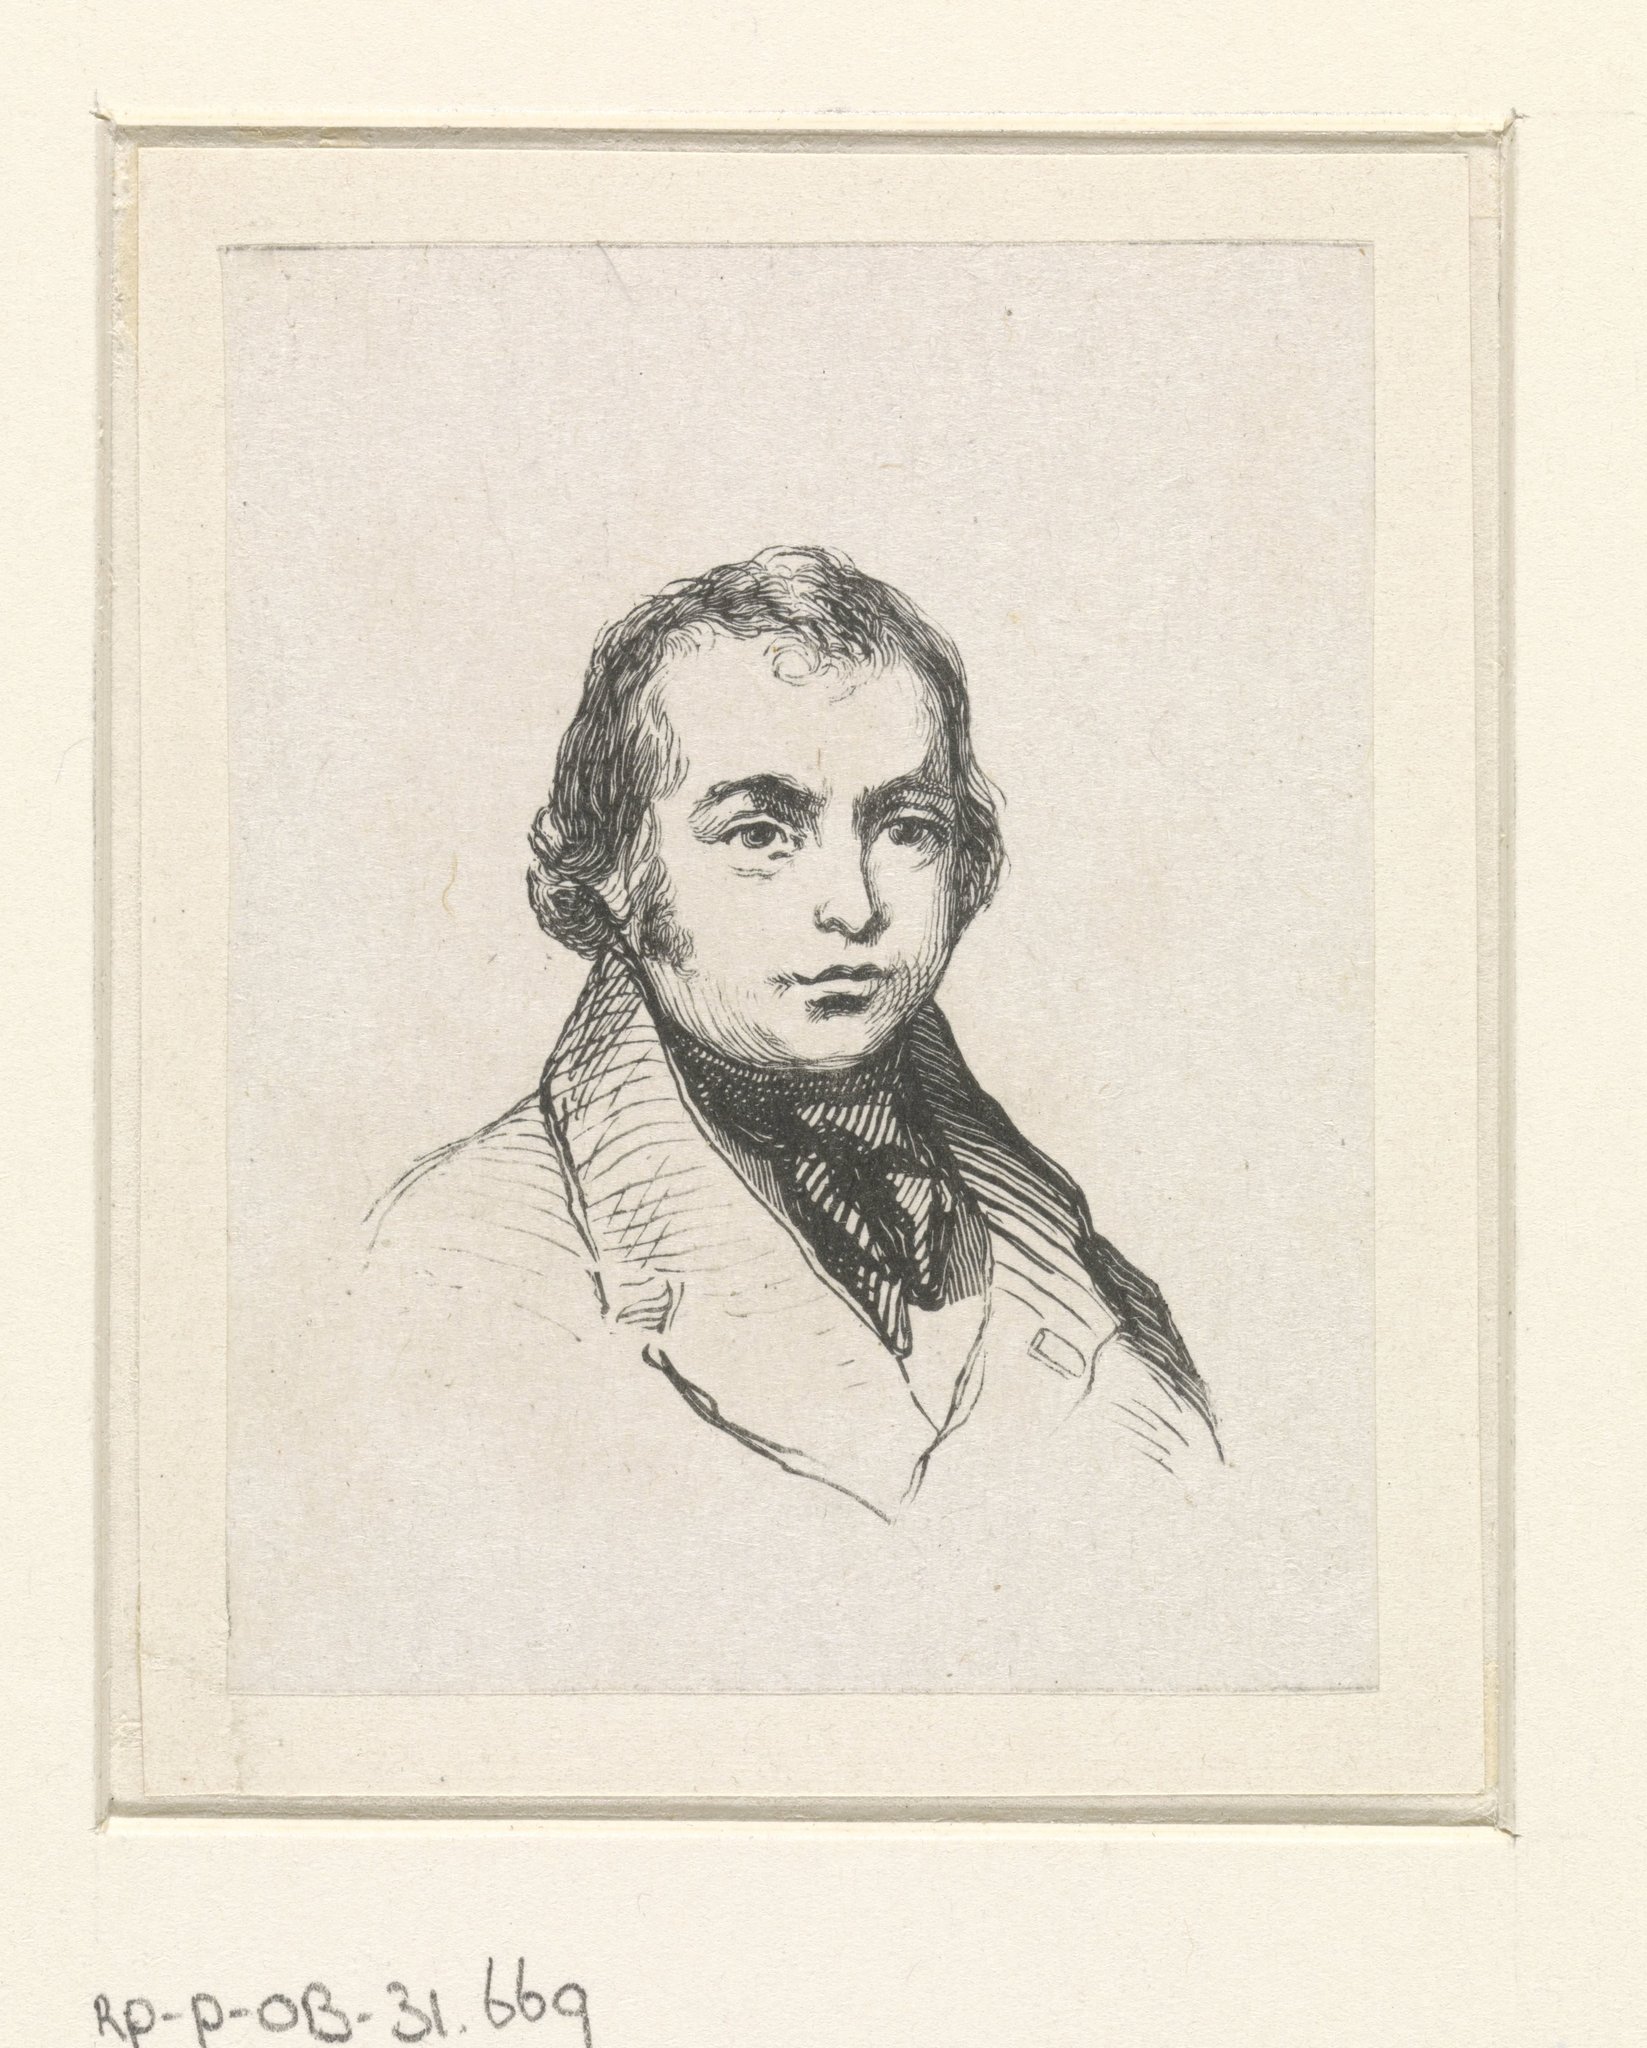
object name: print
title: Portret van Ferdinand de Braekeleer de Oude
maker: Anonymous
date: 1841-1842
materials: paper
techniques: engraving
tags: antwerp, print maker, ferdinand de braekeleer (i), historical persons, portrait, self-portrait of painter, portrait, self-portrait of artist, portrait, self-portrait of draughtsman